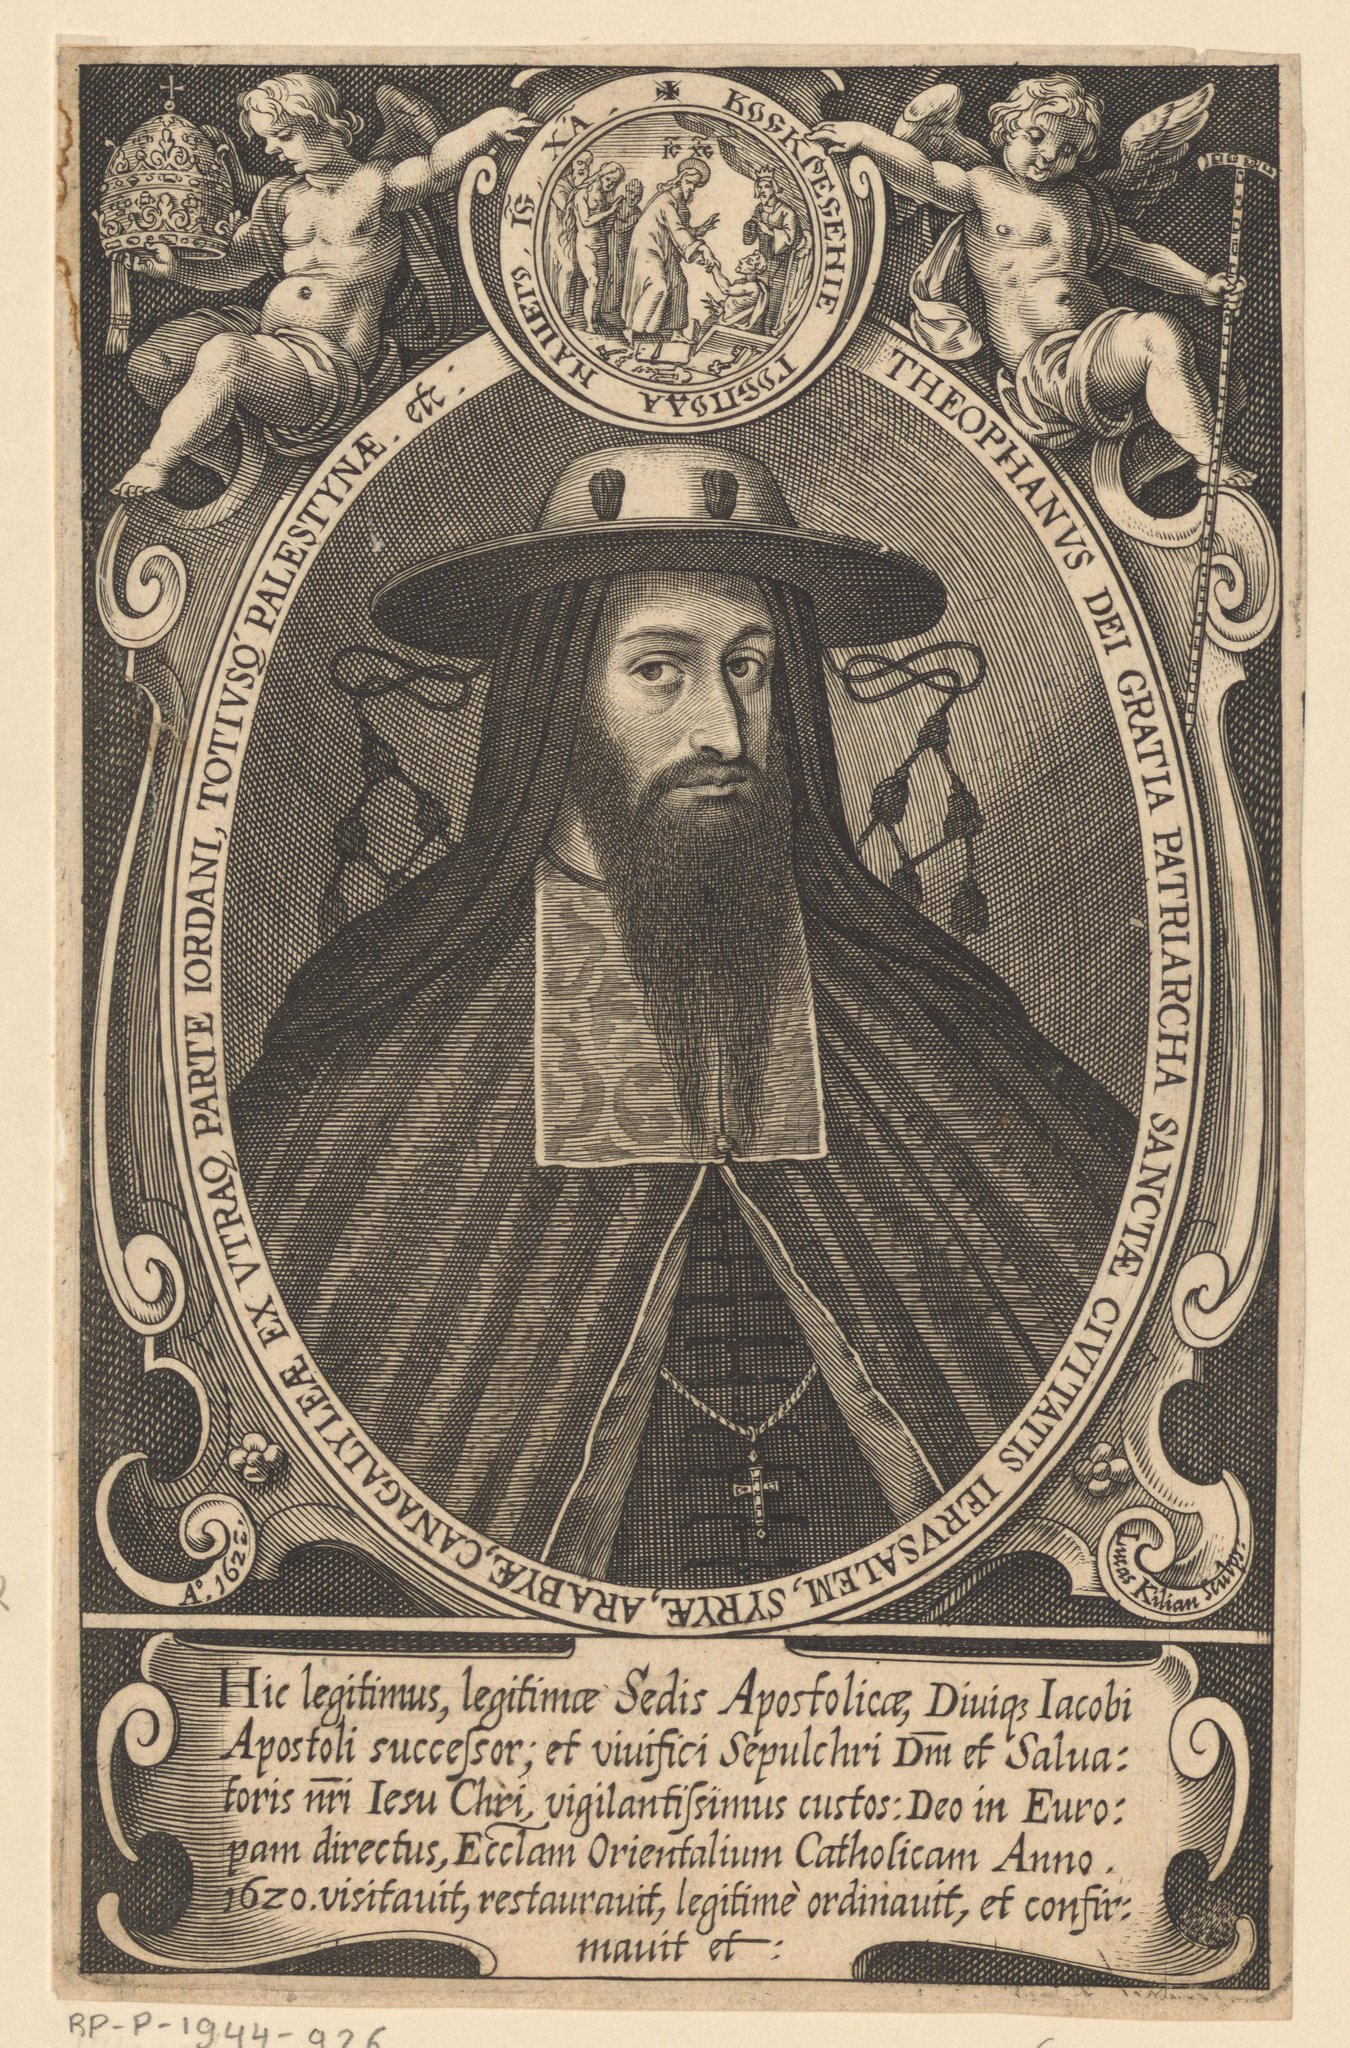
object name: print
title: Portret van Theophanes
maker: lucas kilian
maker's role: draughtsman, print maker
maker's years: 1579-1637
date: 1622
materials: paper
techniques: engraving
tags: historical persons, organizational aspects ~ eastern, greek and russian orthodox churches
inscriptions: collector's mark: Lugt 2228